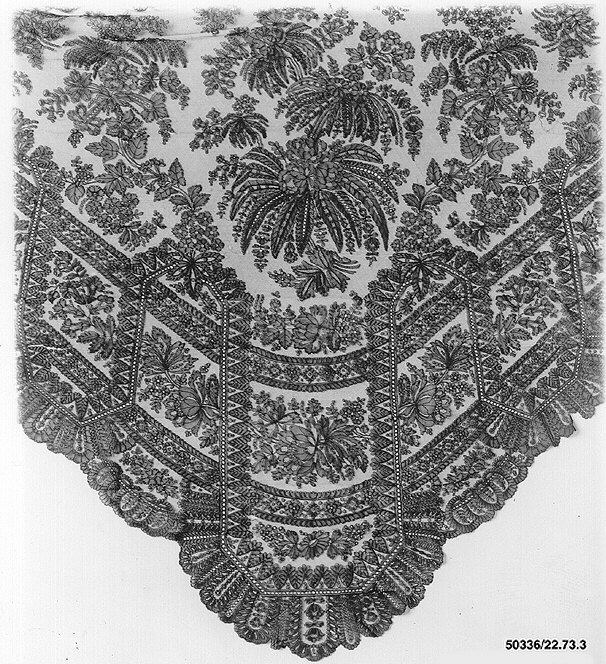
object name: shawl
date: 1801-1900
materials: silk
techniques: lace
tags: flowers